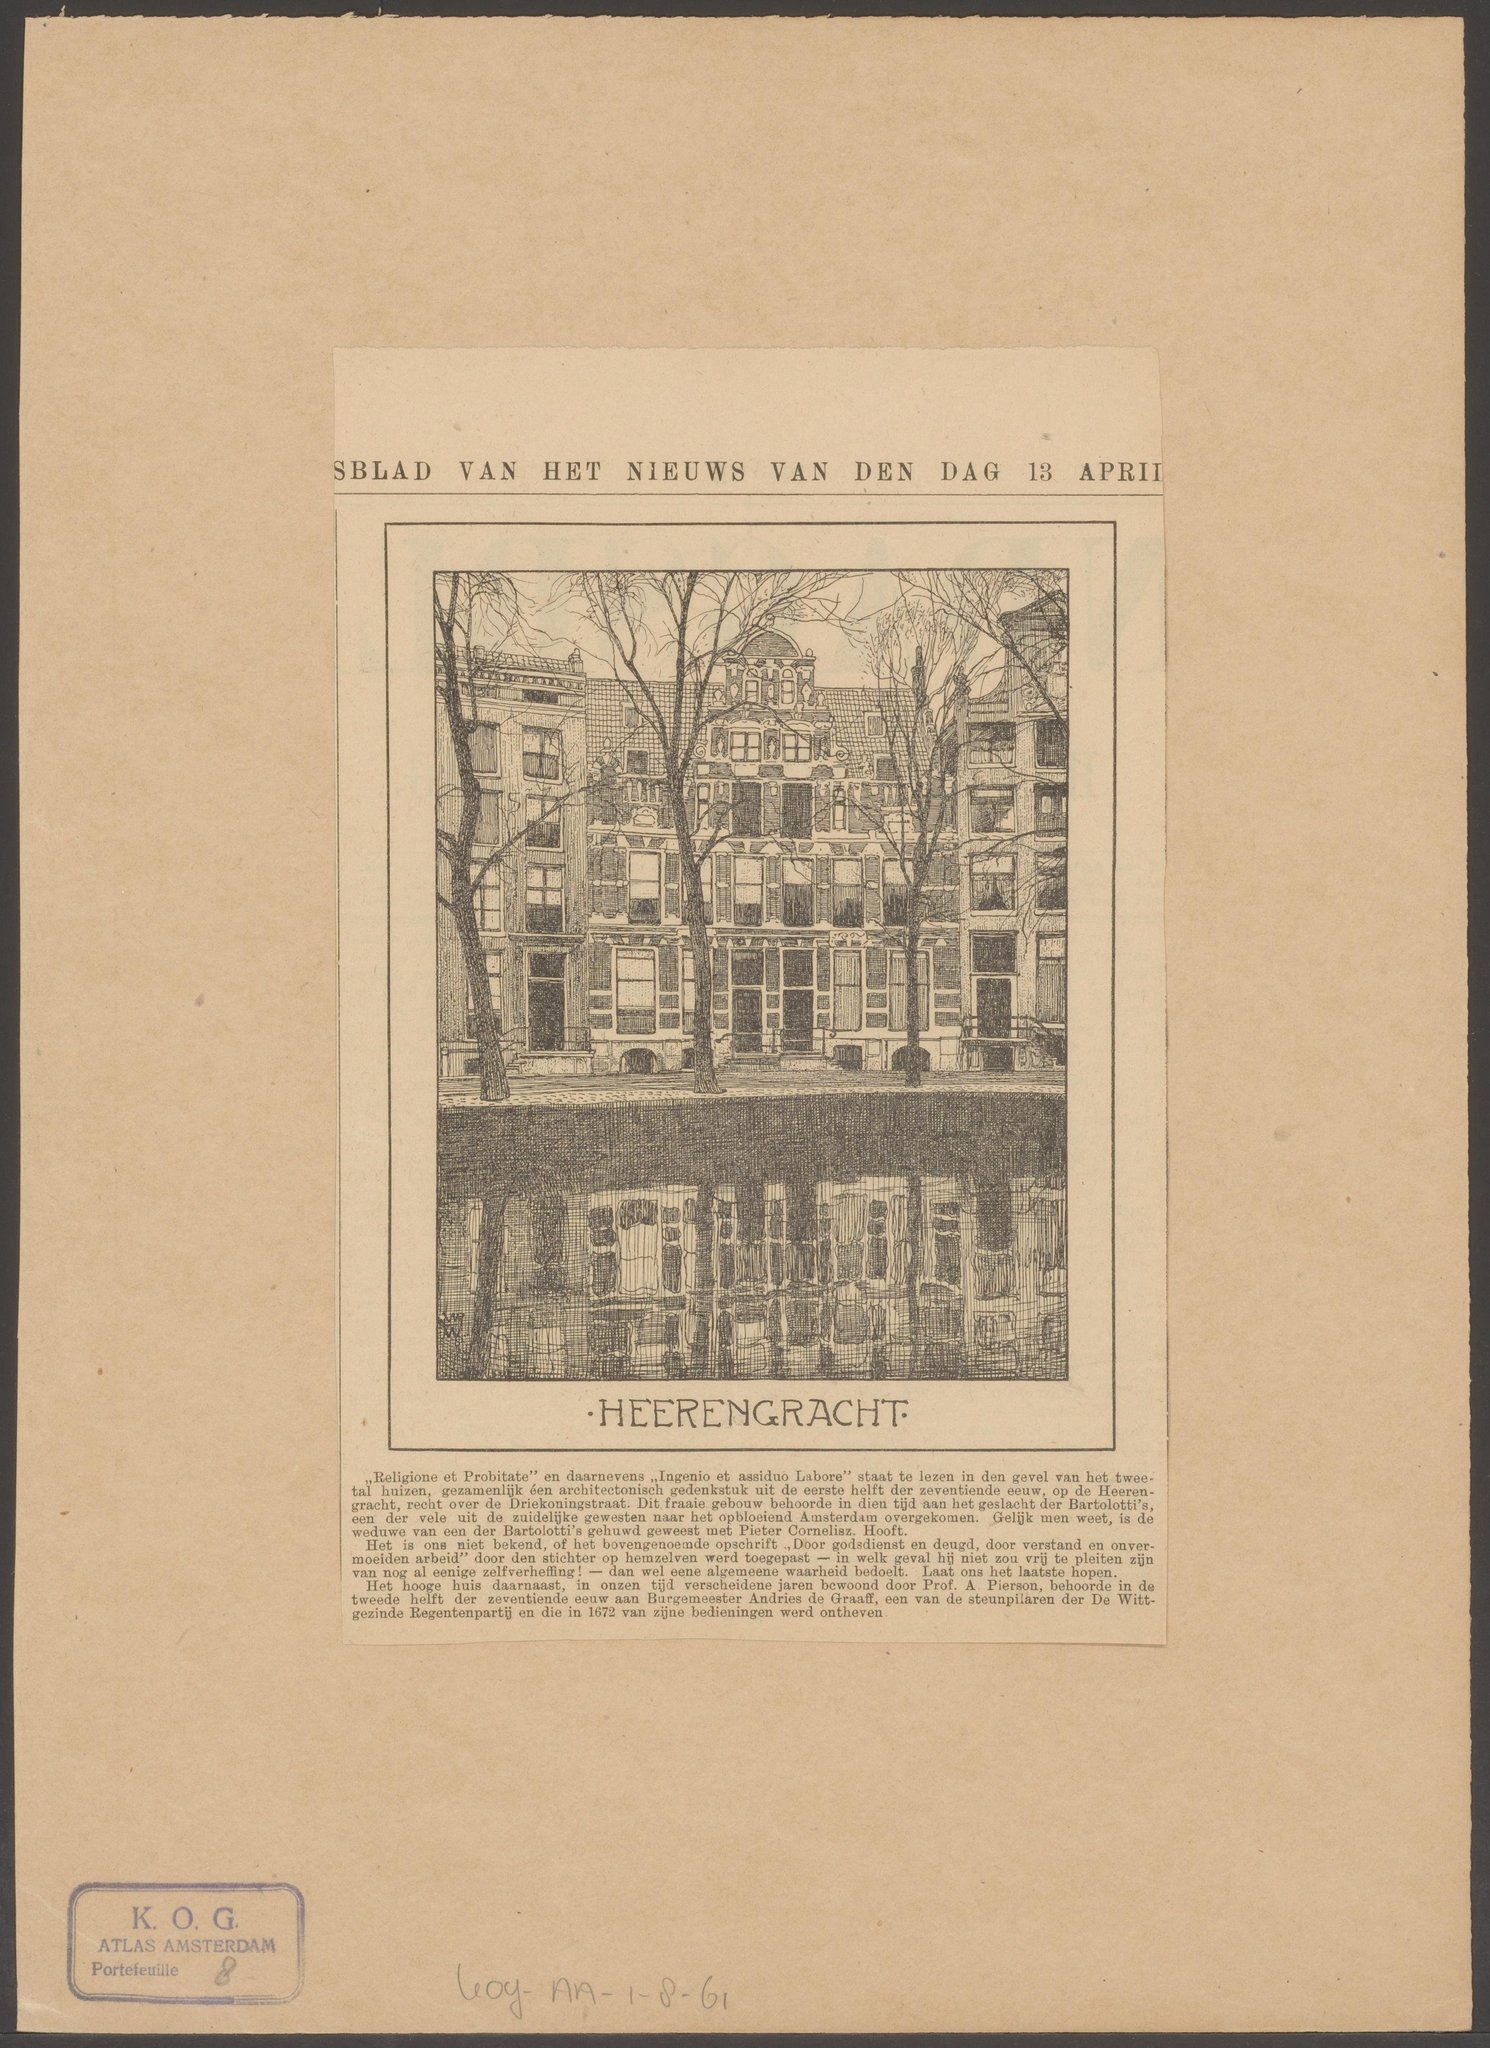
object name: page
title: Gezicht op de Herengracht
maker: willem wenckebach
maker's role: designer, draughtsman, painter, print maker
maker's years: 1860-1937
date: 1870-1923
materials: paper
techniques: letterpress printing, line block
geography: amsterdam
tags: city-view in general; 'veduta', canal, the usual house or row of houses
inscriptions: collector's mark: ‘8’ Lugt 1641b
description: Onderwerpsrubriek binnen de Atlas Amsterdam: Haarlemmerplein, Halvemaansteeg, Handboogstraat, Handelskade, Haringpakkerij, Hartenstraat, Hasseltsteeg (Dirk van), Heerengracht.